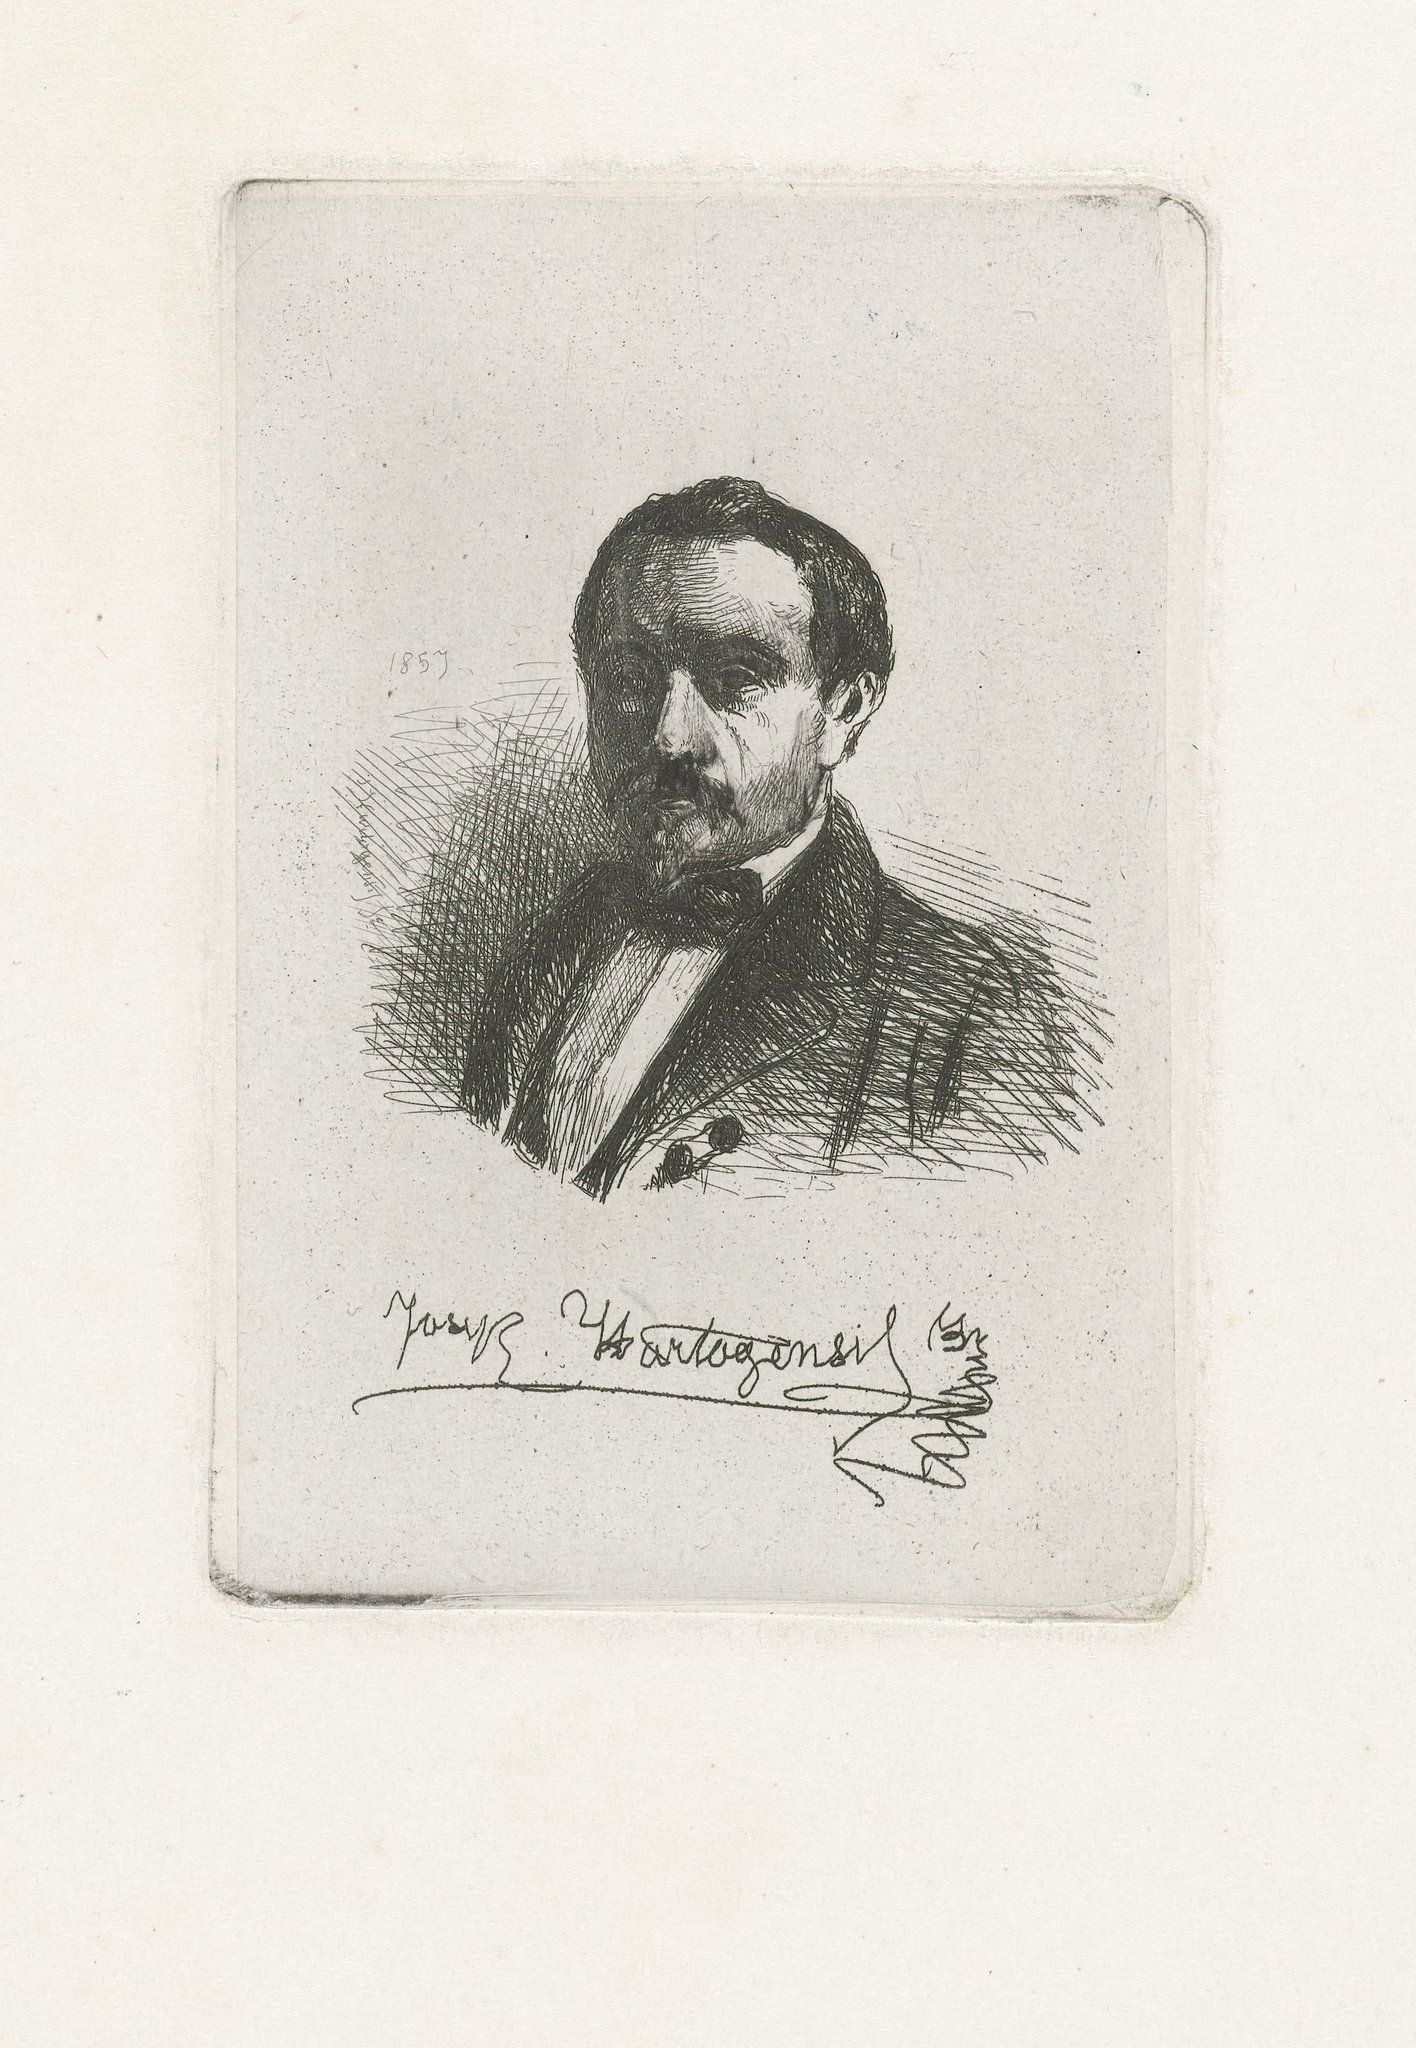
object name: print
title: Zelfportret van Joseph Hartogensis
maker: joseph hartogensis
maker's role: painter, print maker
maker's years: 1822-1865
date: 1857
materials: paper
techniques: etching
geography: the hague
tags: den bosch, painter, print maker, joseph hartogensis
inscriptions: collector's mark: Lugt 2228, collector's mark: Lugt 2760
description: Buste naar links van Joseph Hartogensis.